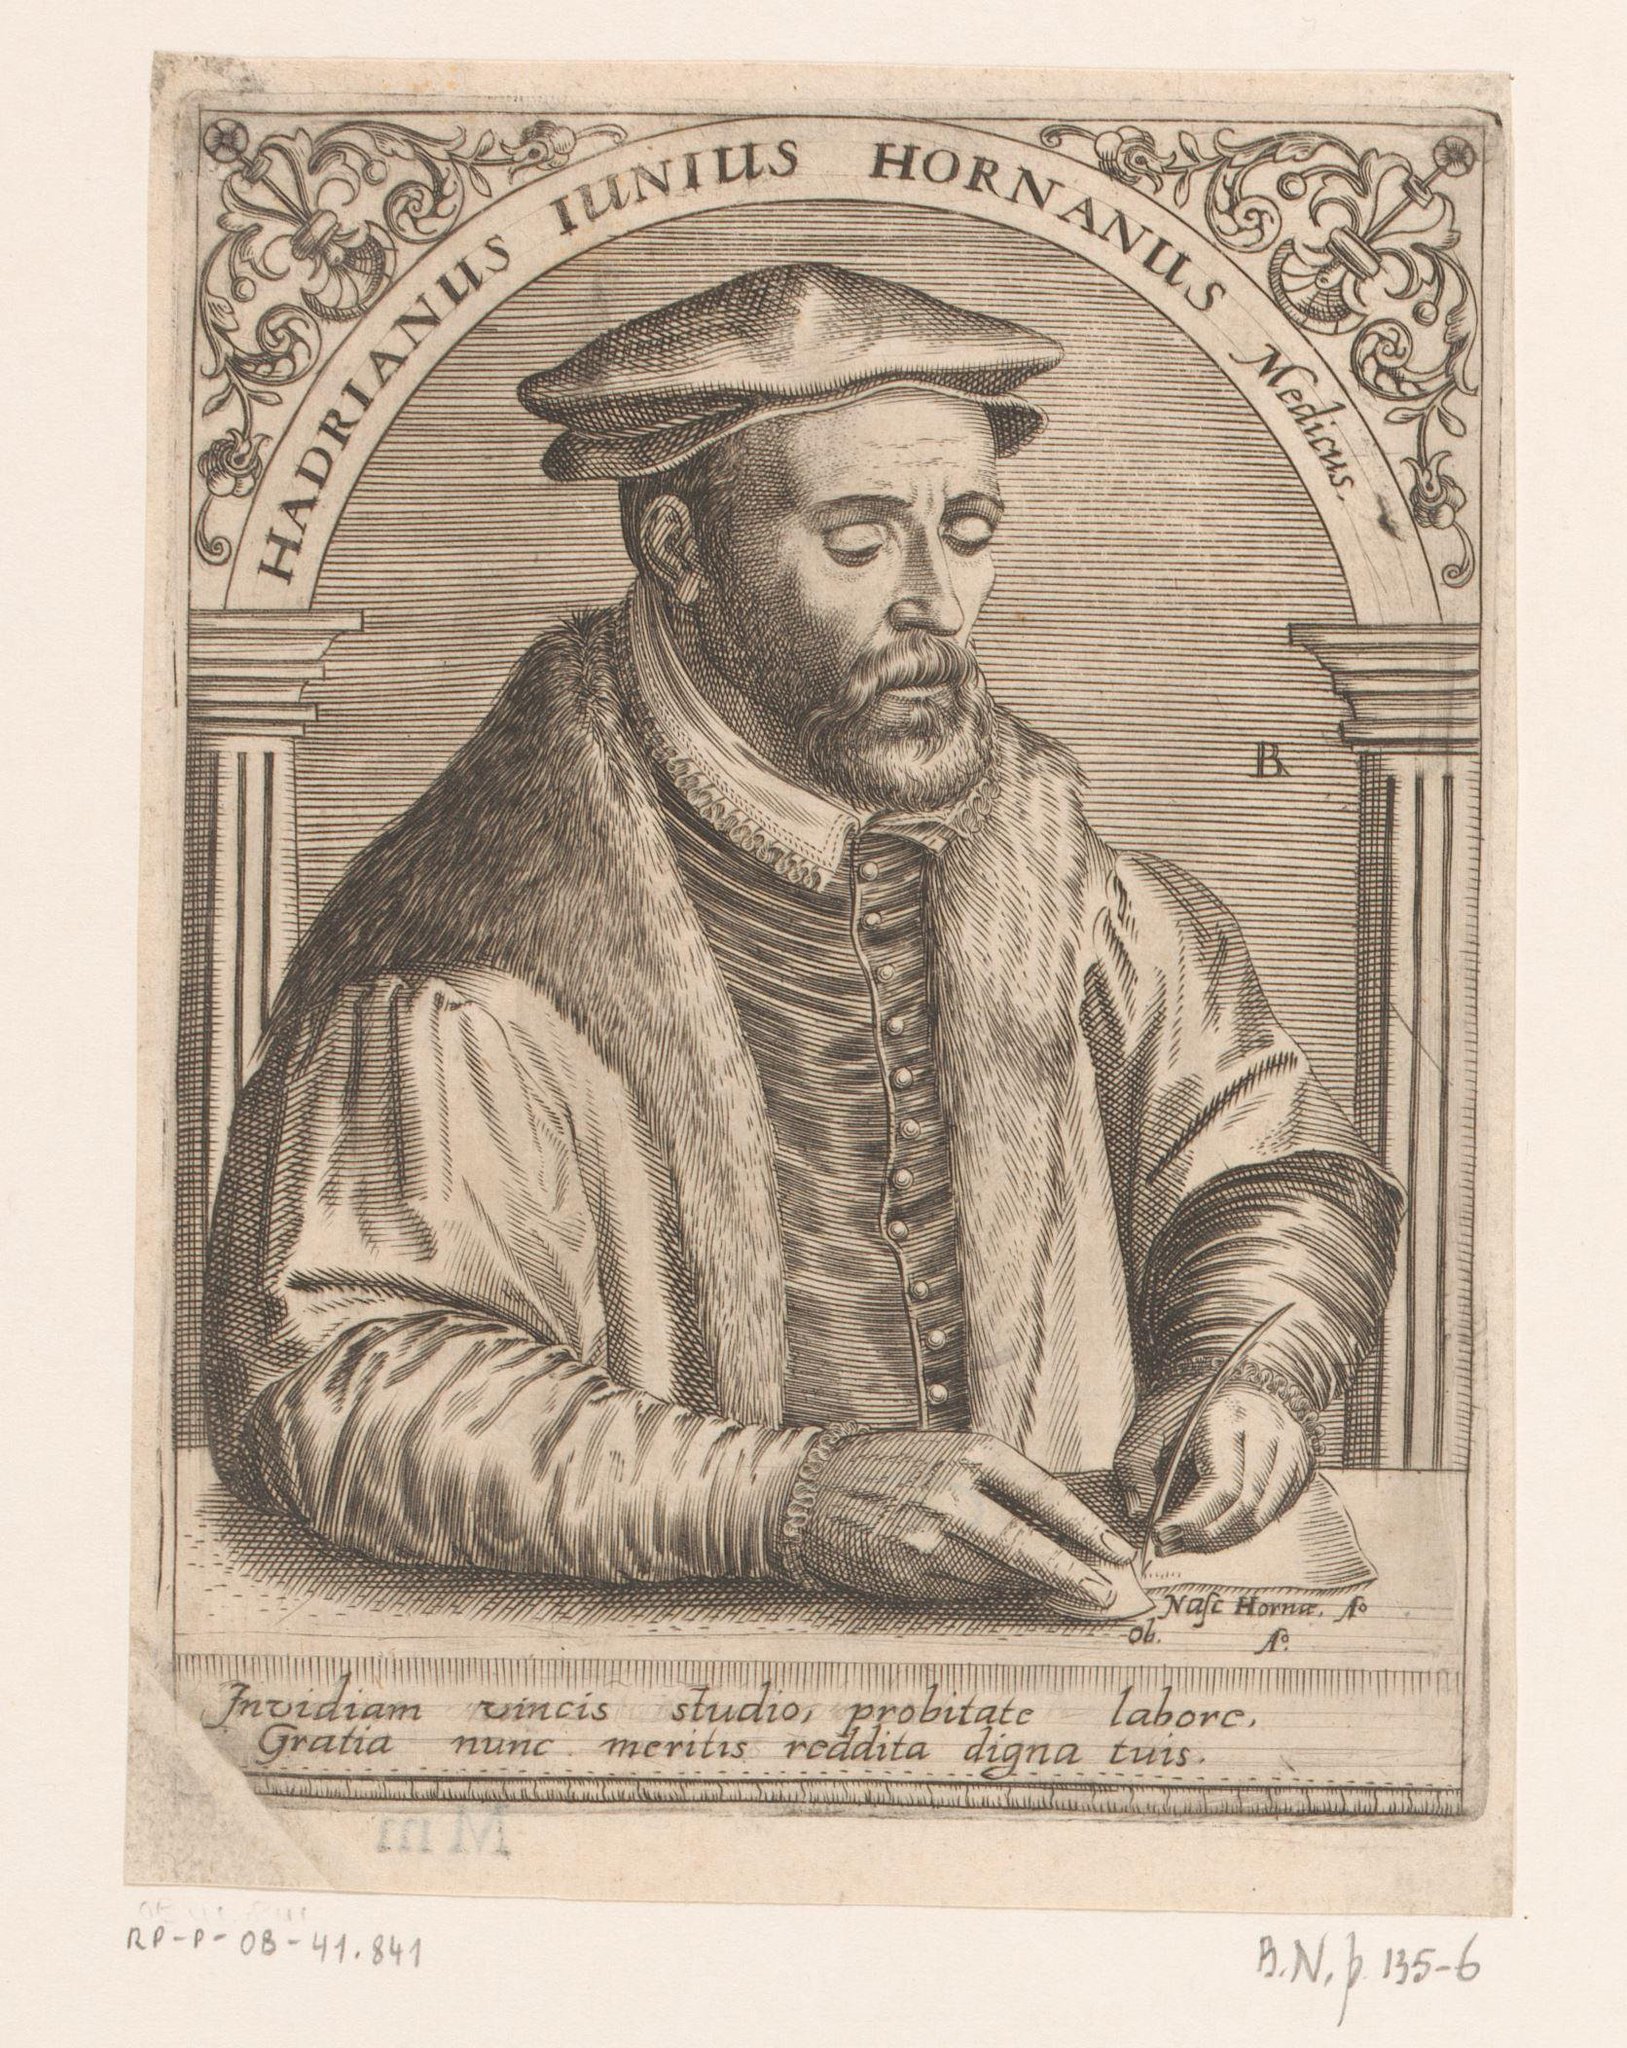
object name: book illustration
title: Serie portretten van vijftiende- en zestiende-eeuwse geleerden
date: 1597-1599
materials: paper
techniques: engraving, letterpress printing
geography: france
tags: middelburg, hadrianus junius, quill, historical persons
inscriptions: collector's mark: Lugt 2228